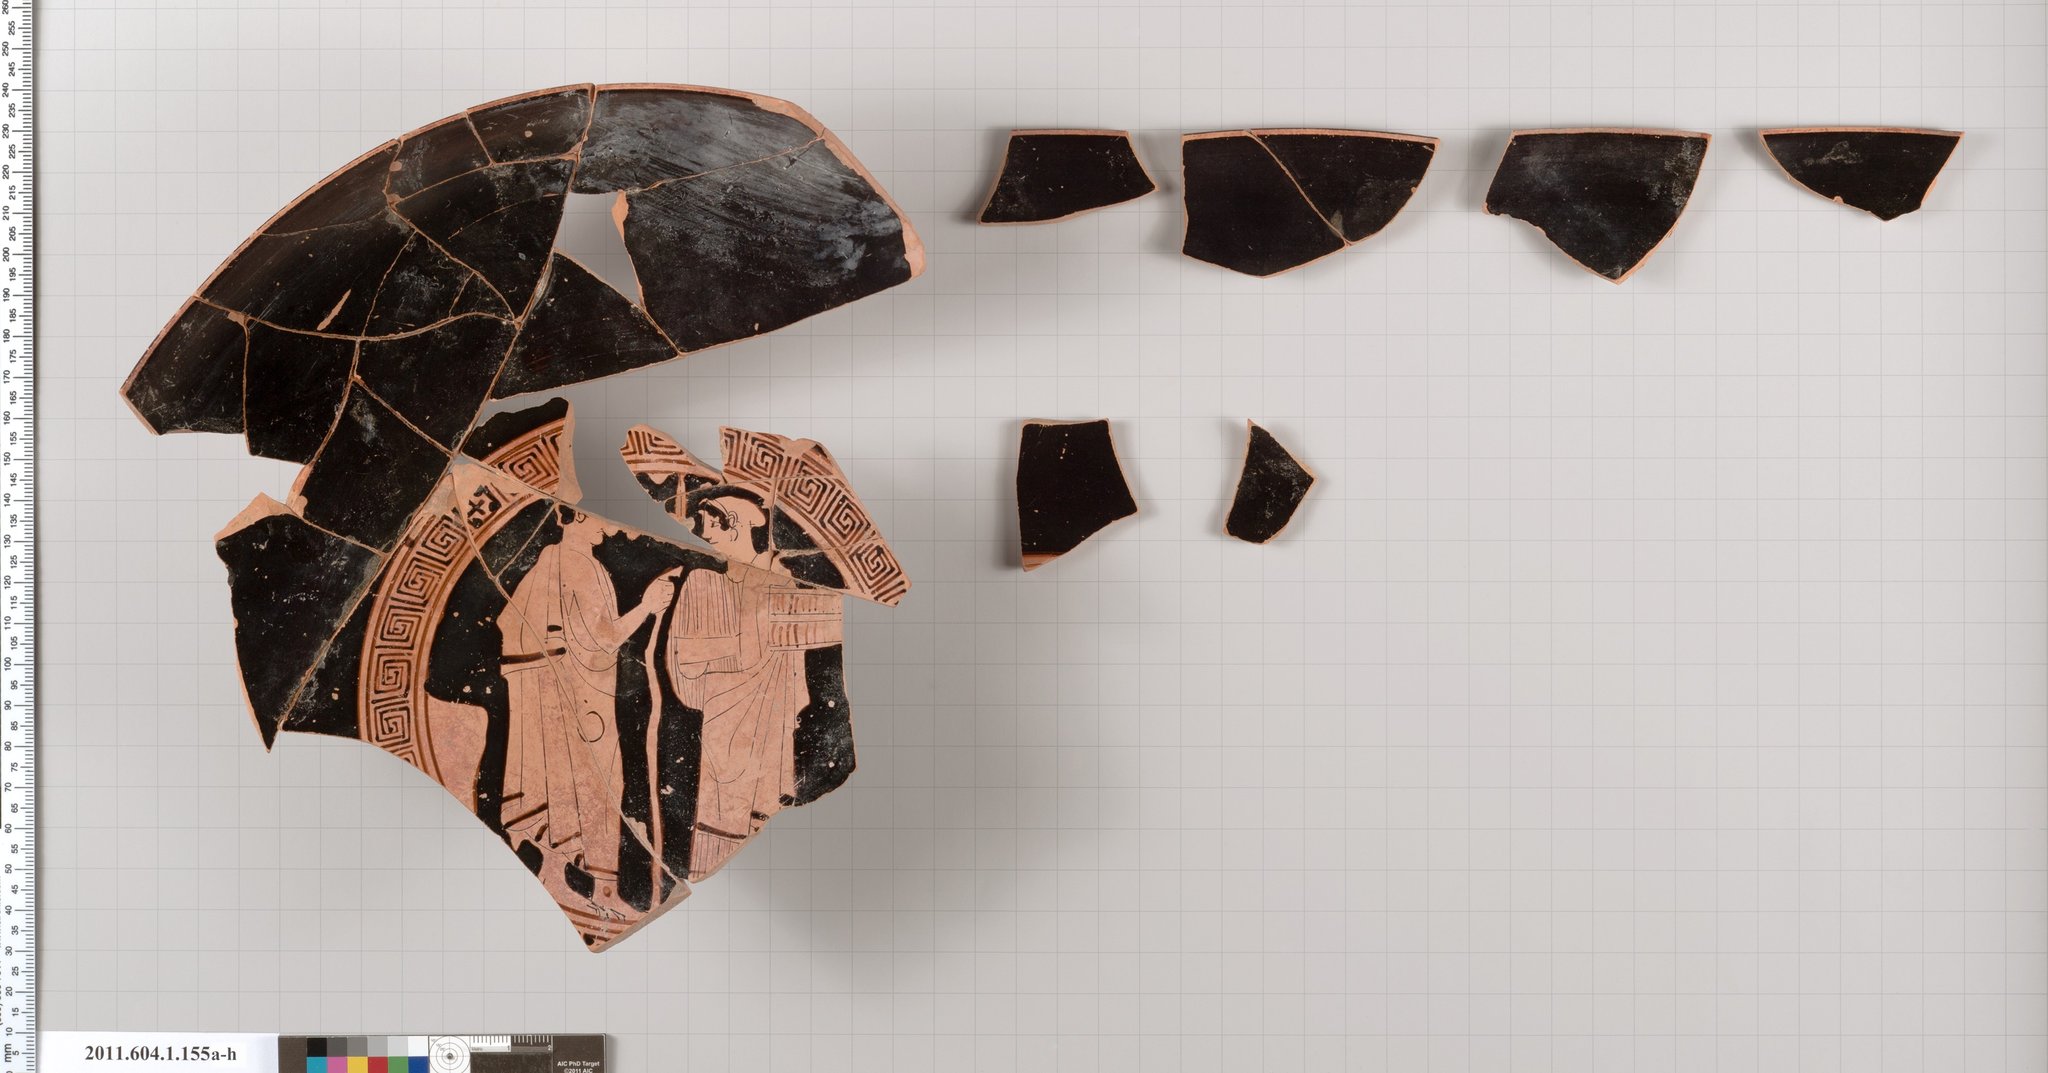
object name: kylix fragment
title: Terracotta fragments of a kylix (drinking cup)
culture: greek, attic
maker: comacchio painter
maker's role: artist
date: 475-451 BCE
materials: terracotta